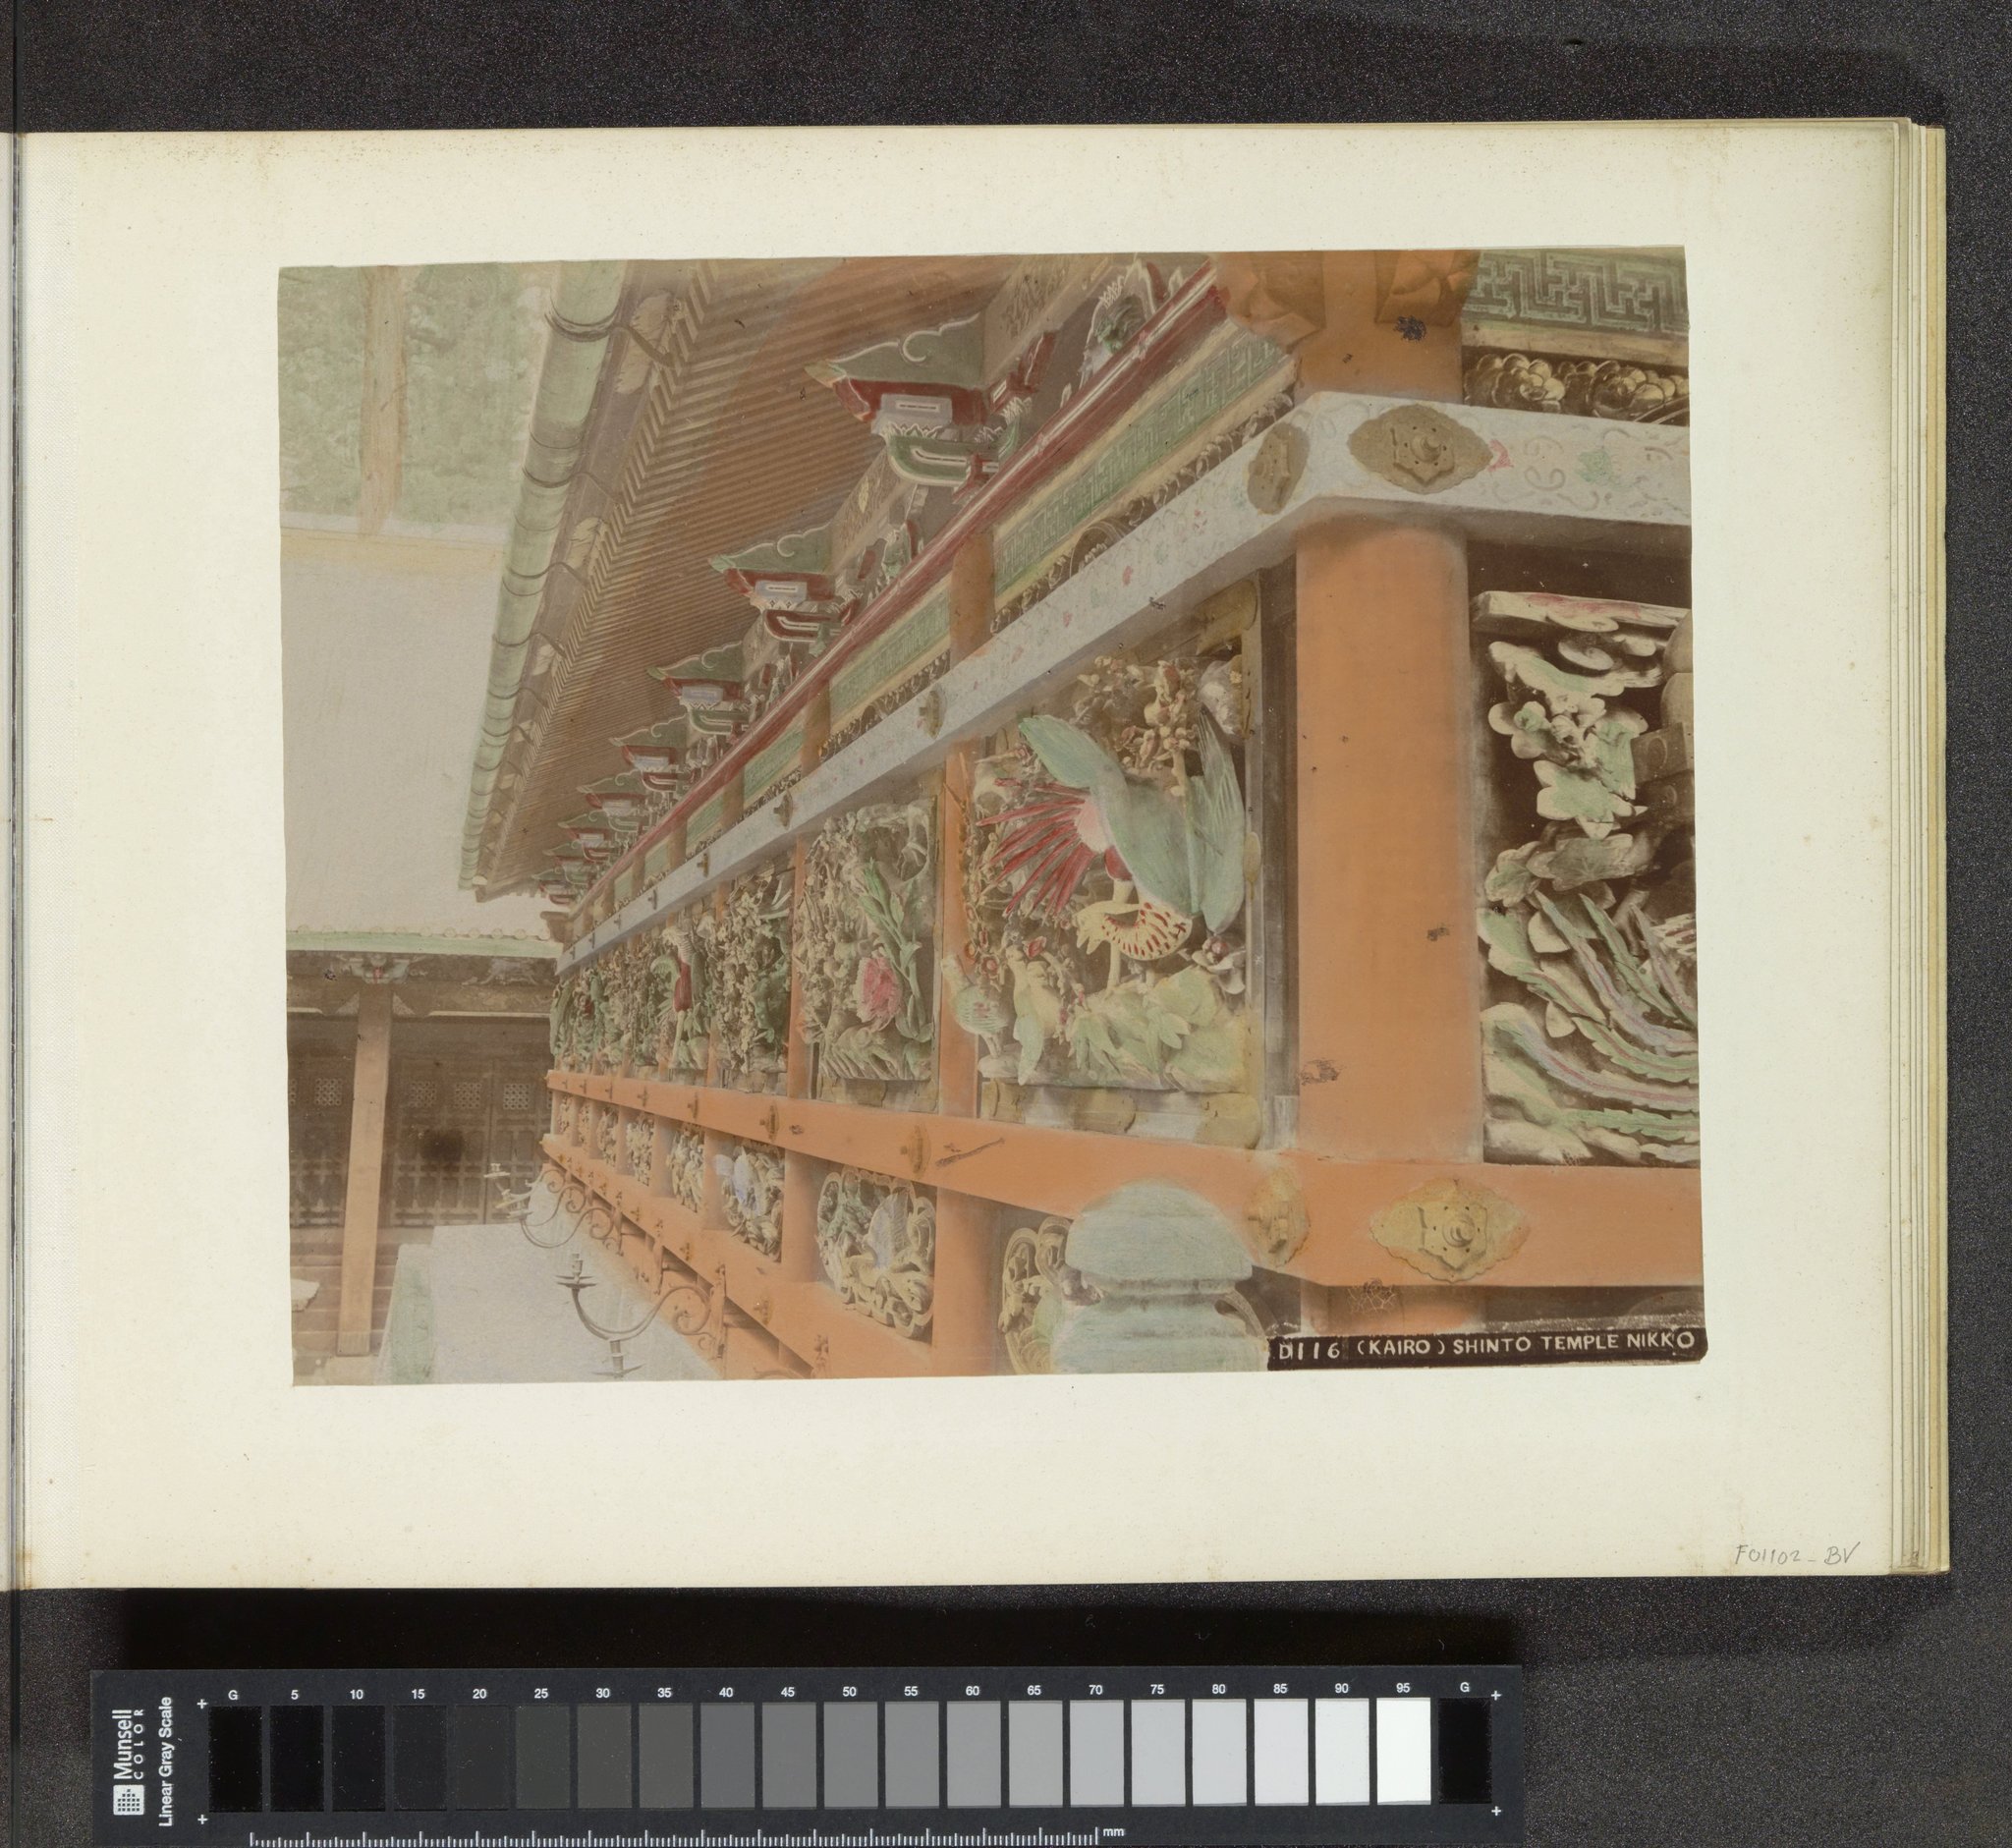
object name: photograph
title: Deel van een Shinto-tempel (Kairo) in Nikko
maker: Anonymous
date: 1870-1900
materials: cardboard, paper, photographic support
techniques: albumen print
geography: nikko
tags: temple, shrine ~ hinduism, buddhism, jainism, sculpture (+ relief ~ sculpture)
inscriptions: negative number: ‘D 116’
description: Onderdeel van Reisalbum met foto's van bezienswaardigheden in Japan.